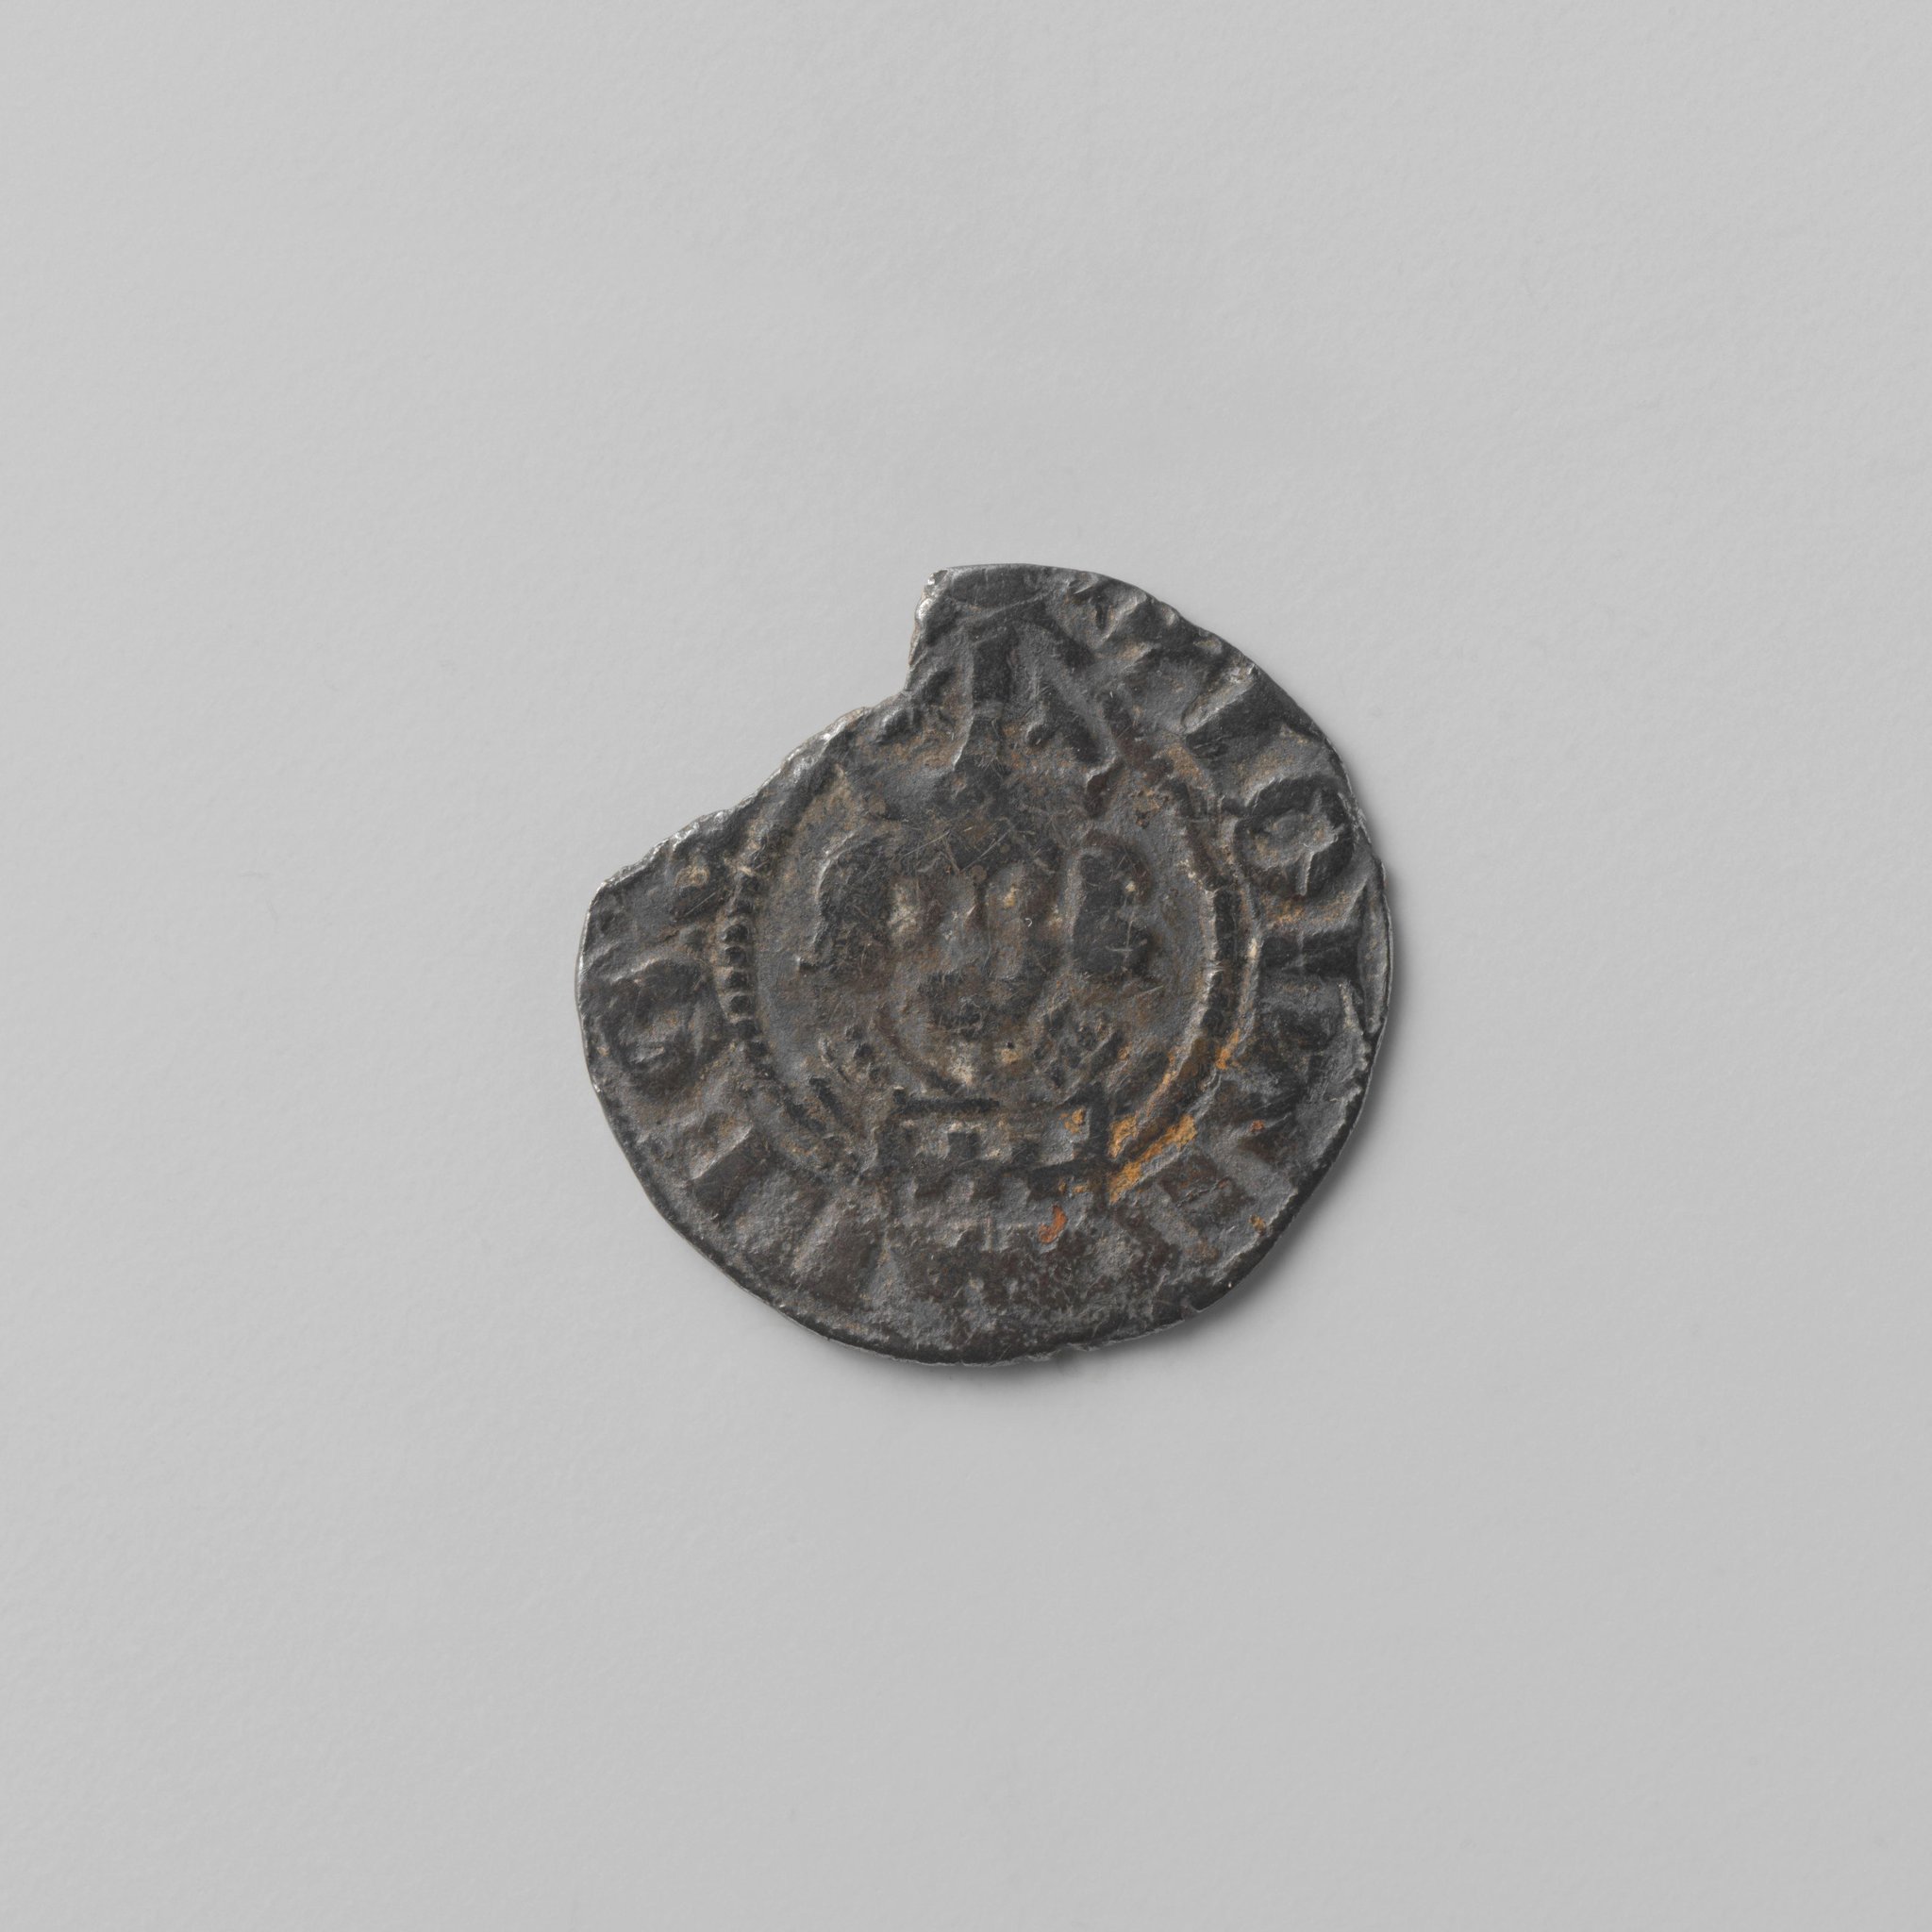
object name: coin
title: Utrechtse kwart groot van Jan van Arkel, 1341-1364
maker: hendrik i van vianden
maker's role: bisschop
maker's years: -1267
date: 1341-1364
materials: silver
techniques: striking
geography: utrecht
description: Zilveren munt. Voorzijde: aanziend portret van de bisschop met mijter met voor zich wapenschild van Arkel. Keerzijde: kort gevoet kruis.